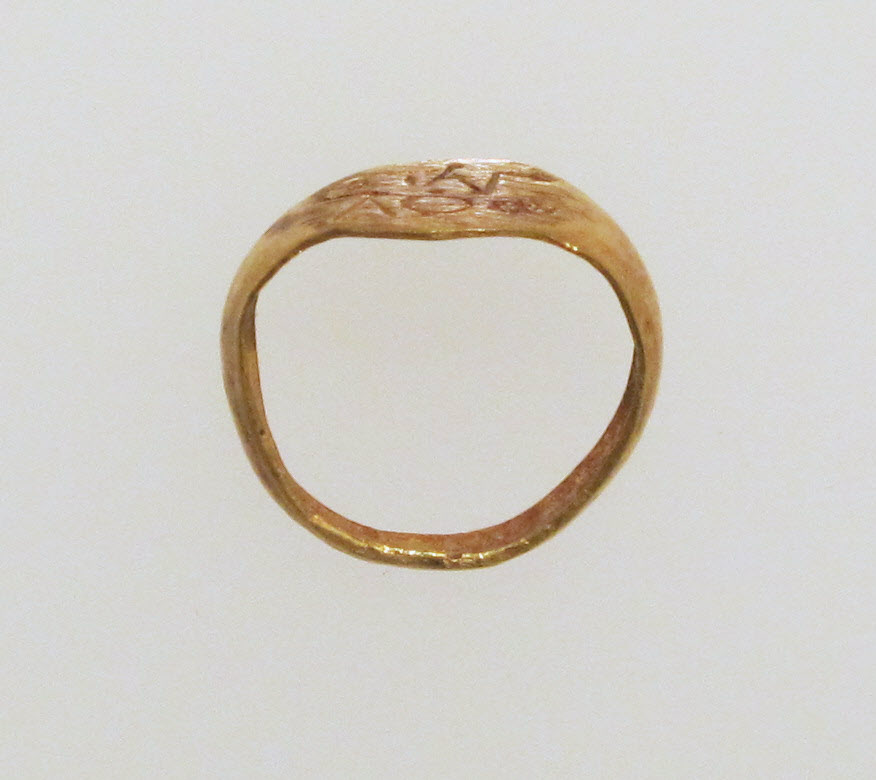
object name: ring, motto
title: Gold ring with inscribed bezel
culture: roman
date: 100 BCE-300 CE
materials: gold